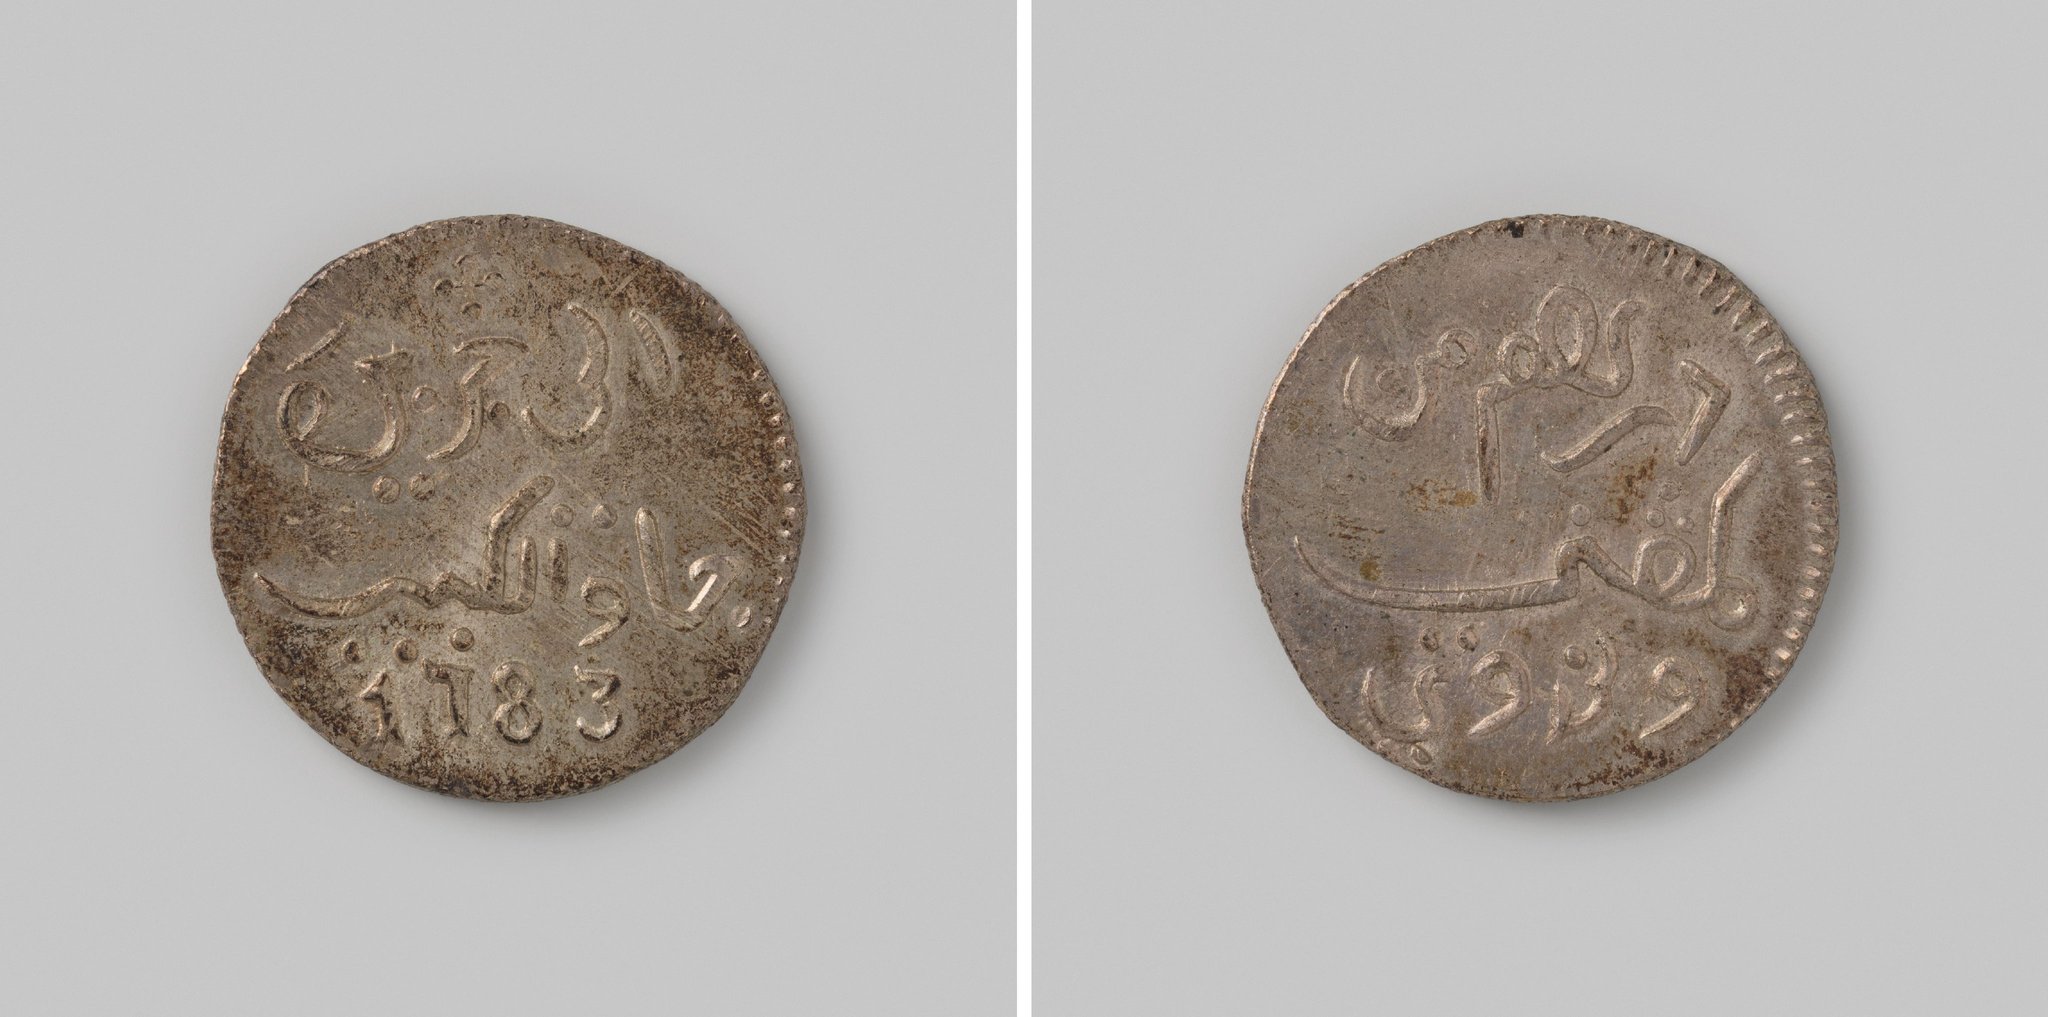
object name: coin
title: VOC, zilveren Javase ropij, 1783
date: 1783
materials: silver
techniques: striking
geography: batavia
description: Zilveren munt. Voorzijde: tweeregelig opschrift in Arabische letters. Daarboven muntteken en daaronder jaartal. Keerzijde: drieregelig opschrift in Arabische letters. Kabelrand.